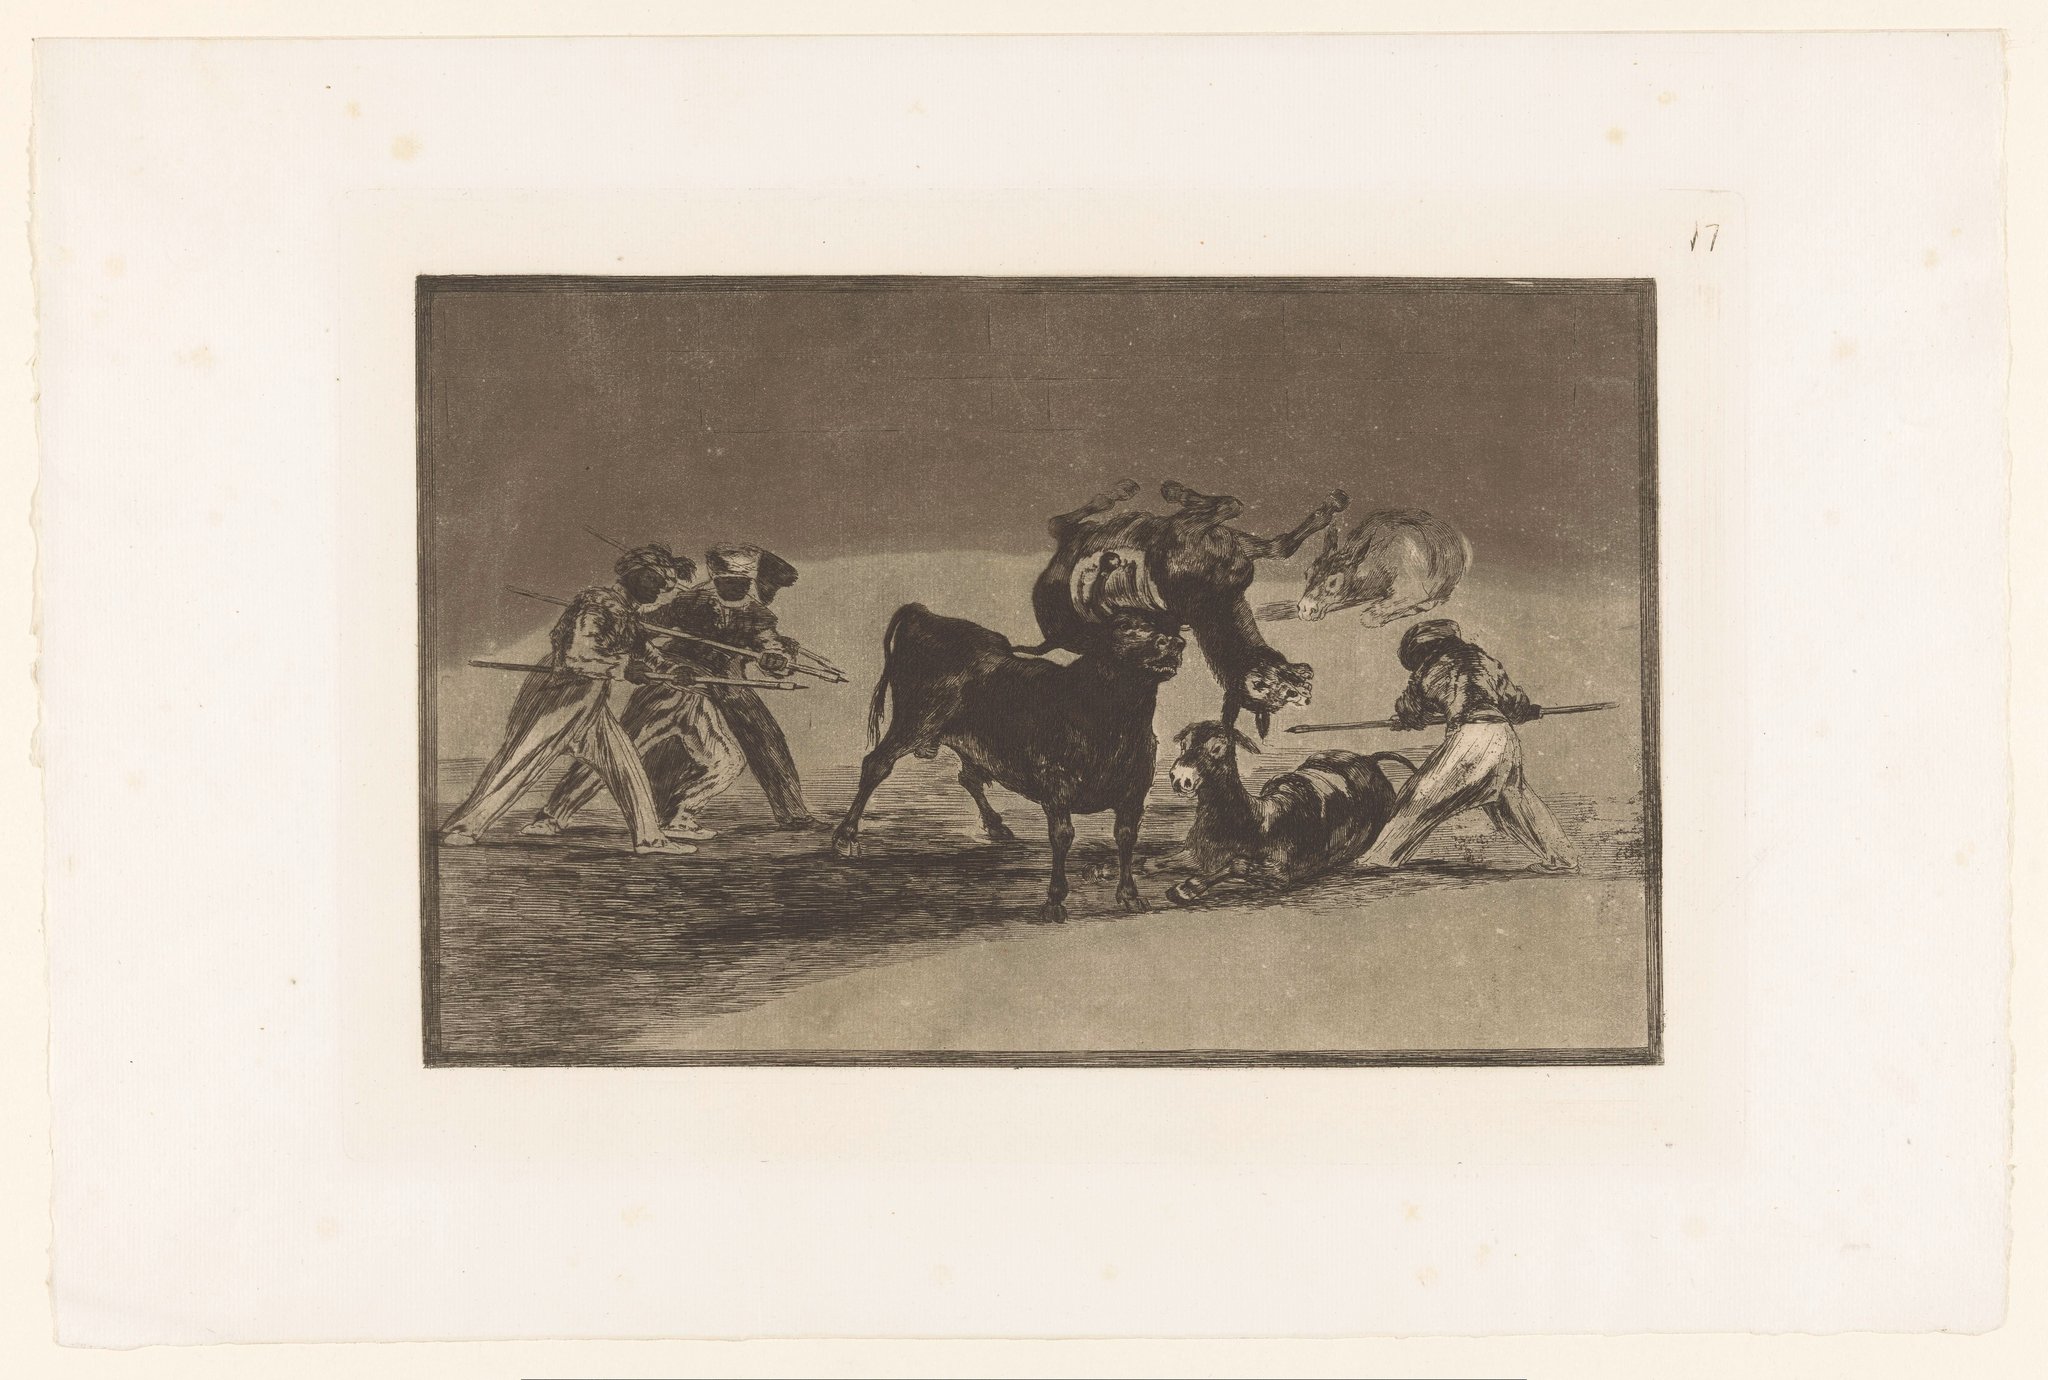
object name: print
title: Palenque de los Moros hecho con burros para defenderse del toro embolado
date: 1876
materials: paper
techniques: aquatint, etching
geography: spain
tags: ass, donkey, bullfight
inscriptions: collector's mark: Lugt 2228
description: Deze prent maakt deel uit van een serie van 40 prenten door Francisco de Goya met voorstellingen van stierengevechten. De eerste editie bestond uit 33 genummerde prenten en werd uitgegeven in 1816. Dit betreft de derde editie, uitgegeven in 1876 door Eugène Loizelet en door hem voorzien van een titelprent en lijst met titels. Naast de 33 prenten publiceerde Loizelet ook de prenten die door Goya op de achterkanten van 7 van de platen werden geëtst. Deze zijn niet voorzien van nummers maar van de letters A-G.